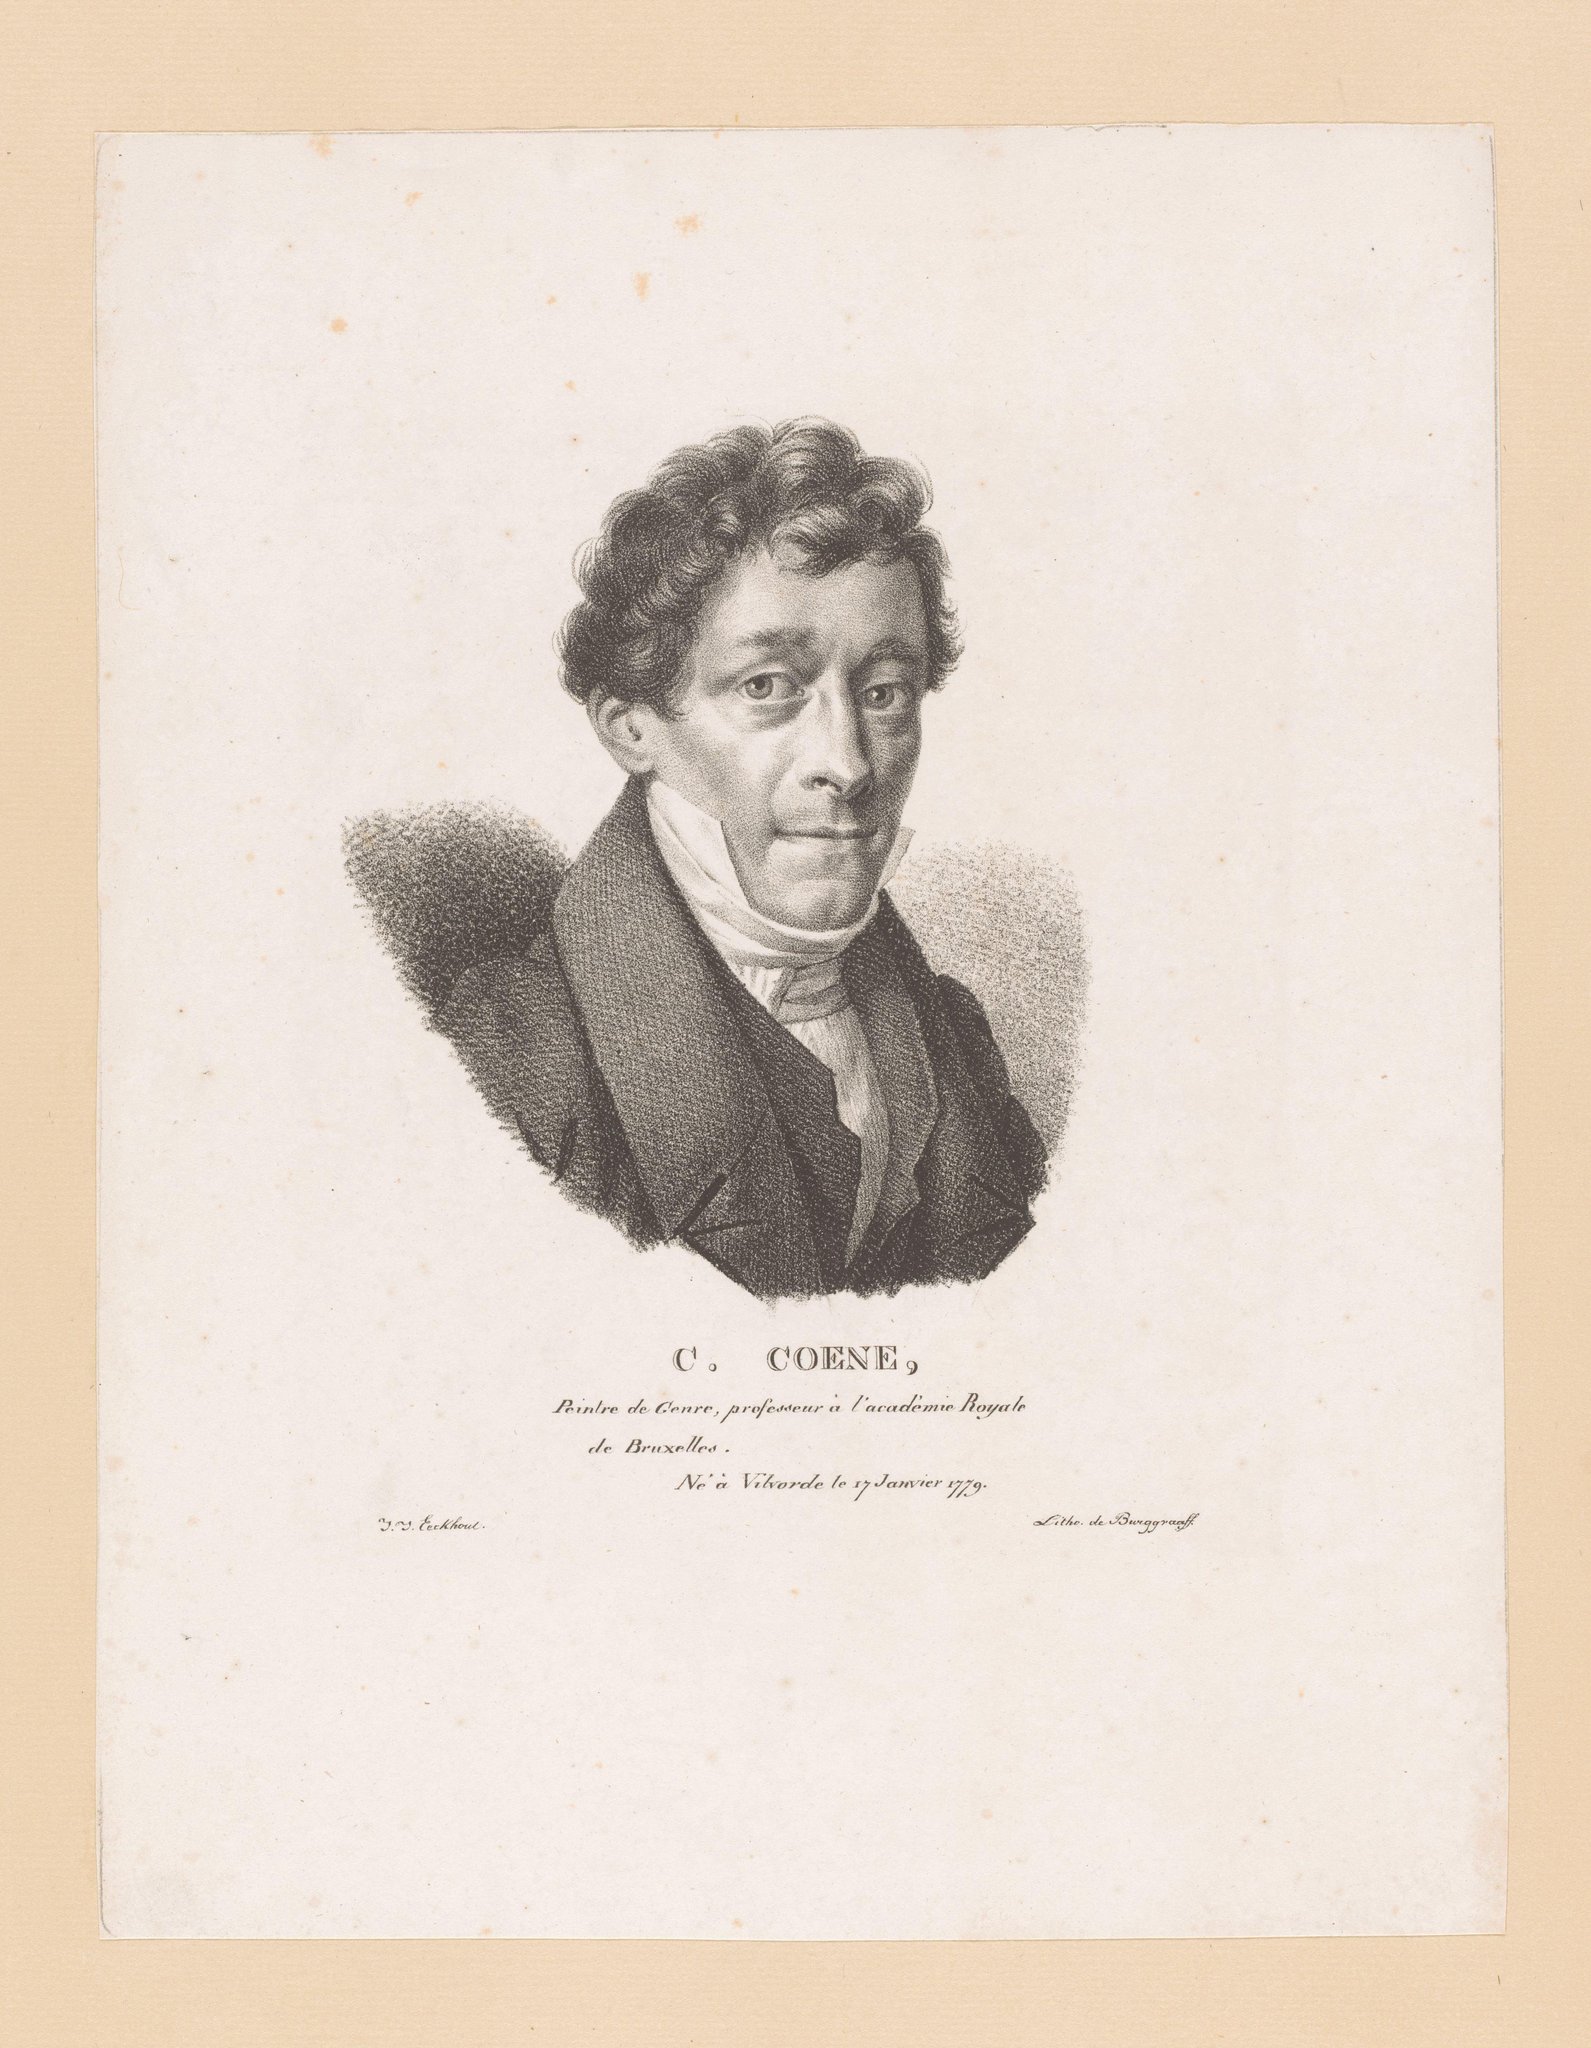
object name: print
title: C. Coene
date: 1822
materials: paper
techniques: lithograph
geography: brussels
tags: brussels, painter, draughtsman, constantinus fidelio coene, historical persons, portrait, self-portrait of painter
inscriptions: collector's mark: Lugt 2228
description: Prent maakt deel uit van een serie van zestig prenten.